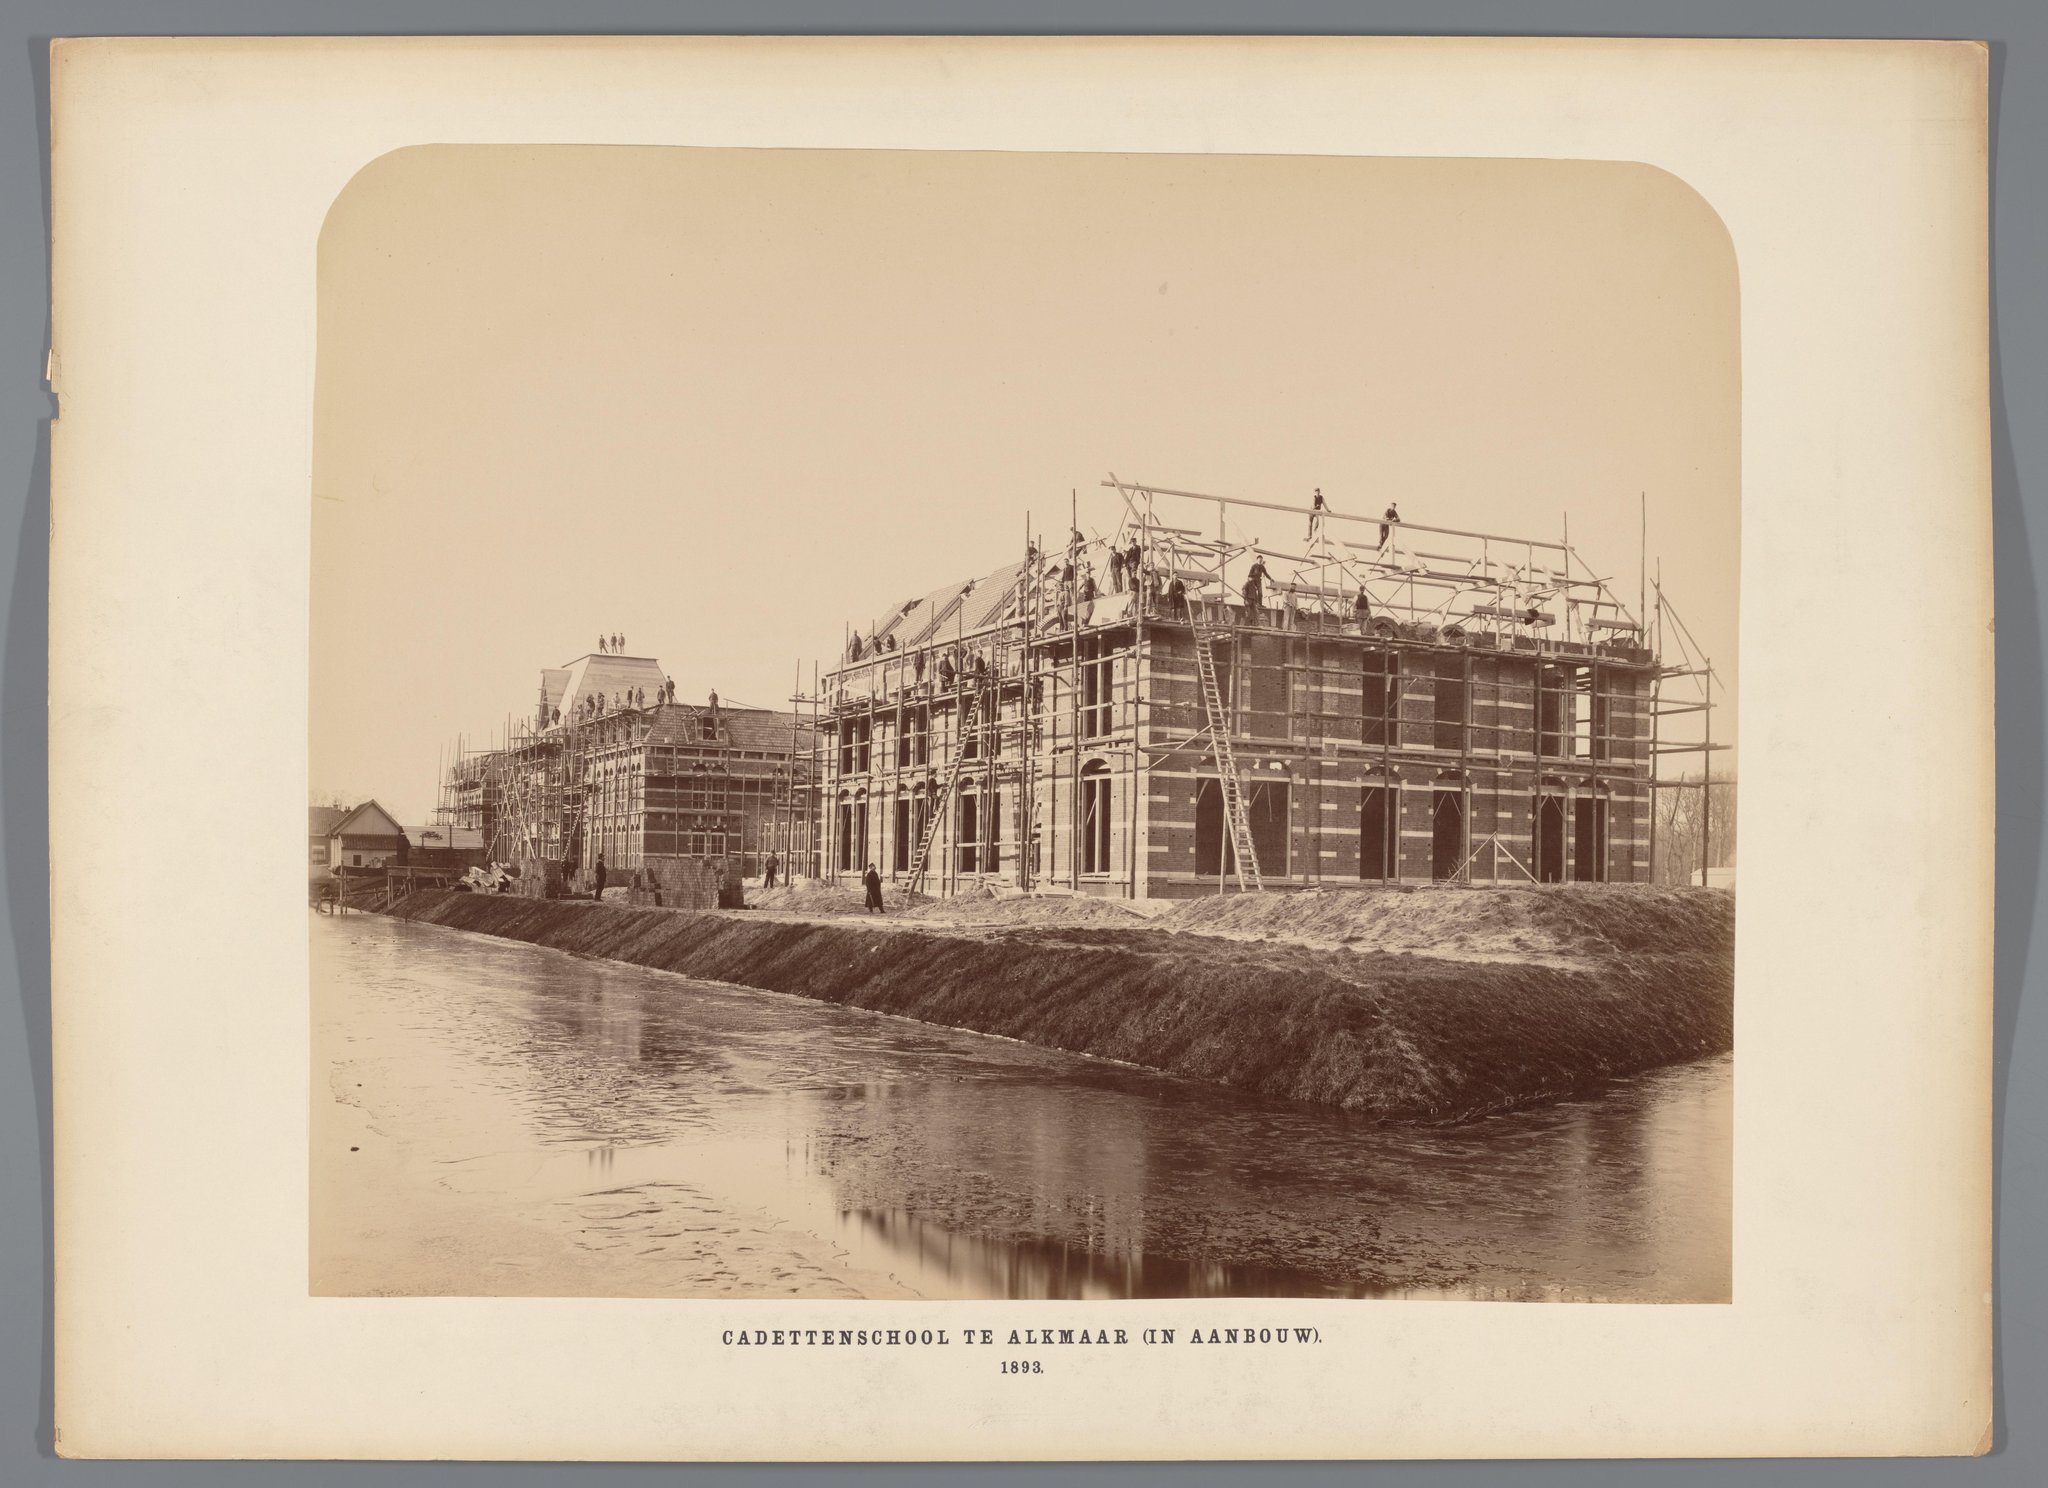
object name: photograph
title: Cadettenschool te Alkmaar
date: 1893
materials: cardboard, paper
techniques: photography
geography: alkmaar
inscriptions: date